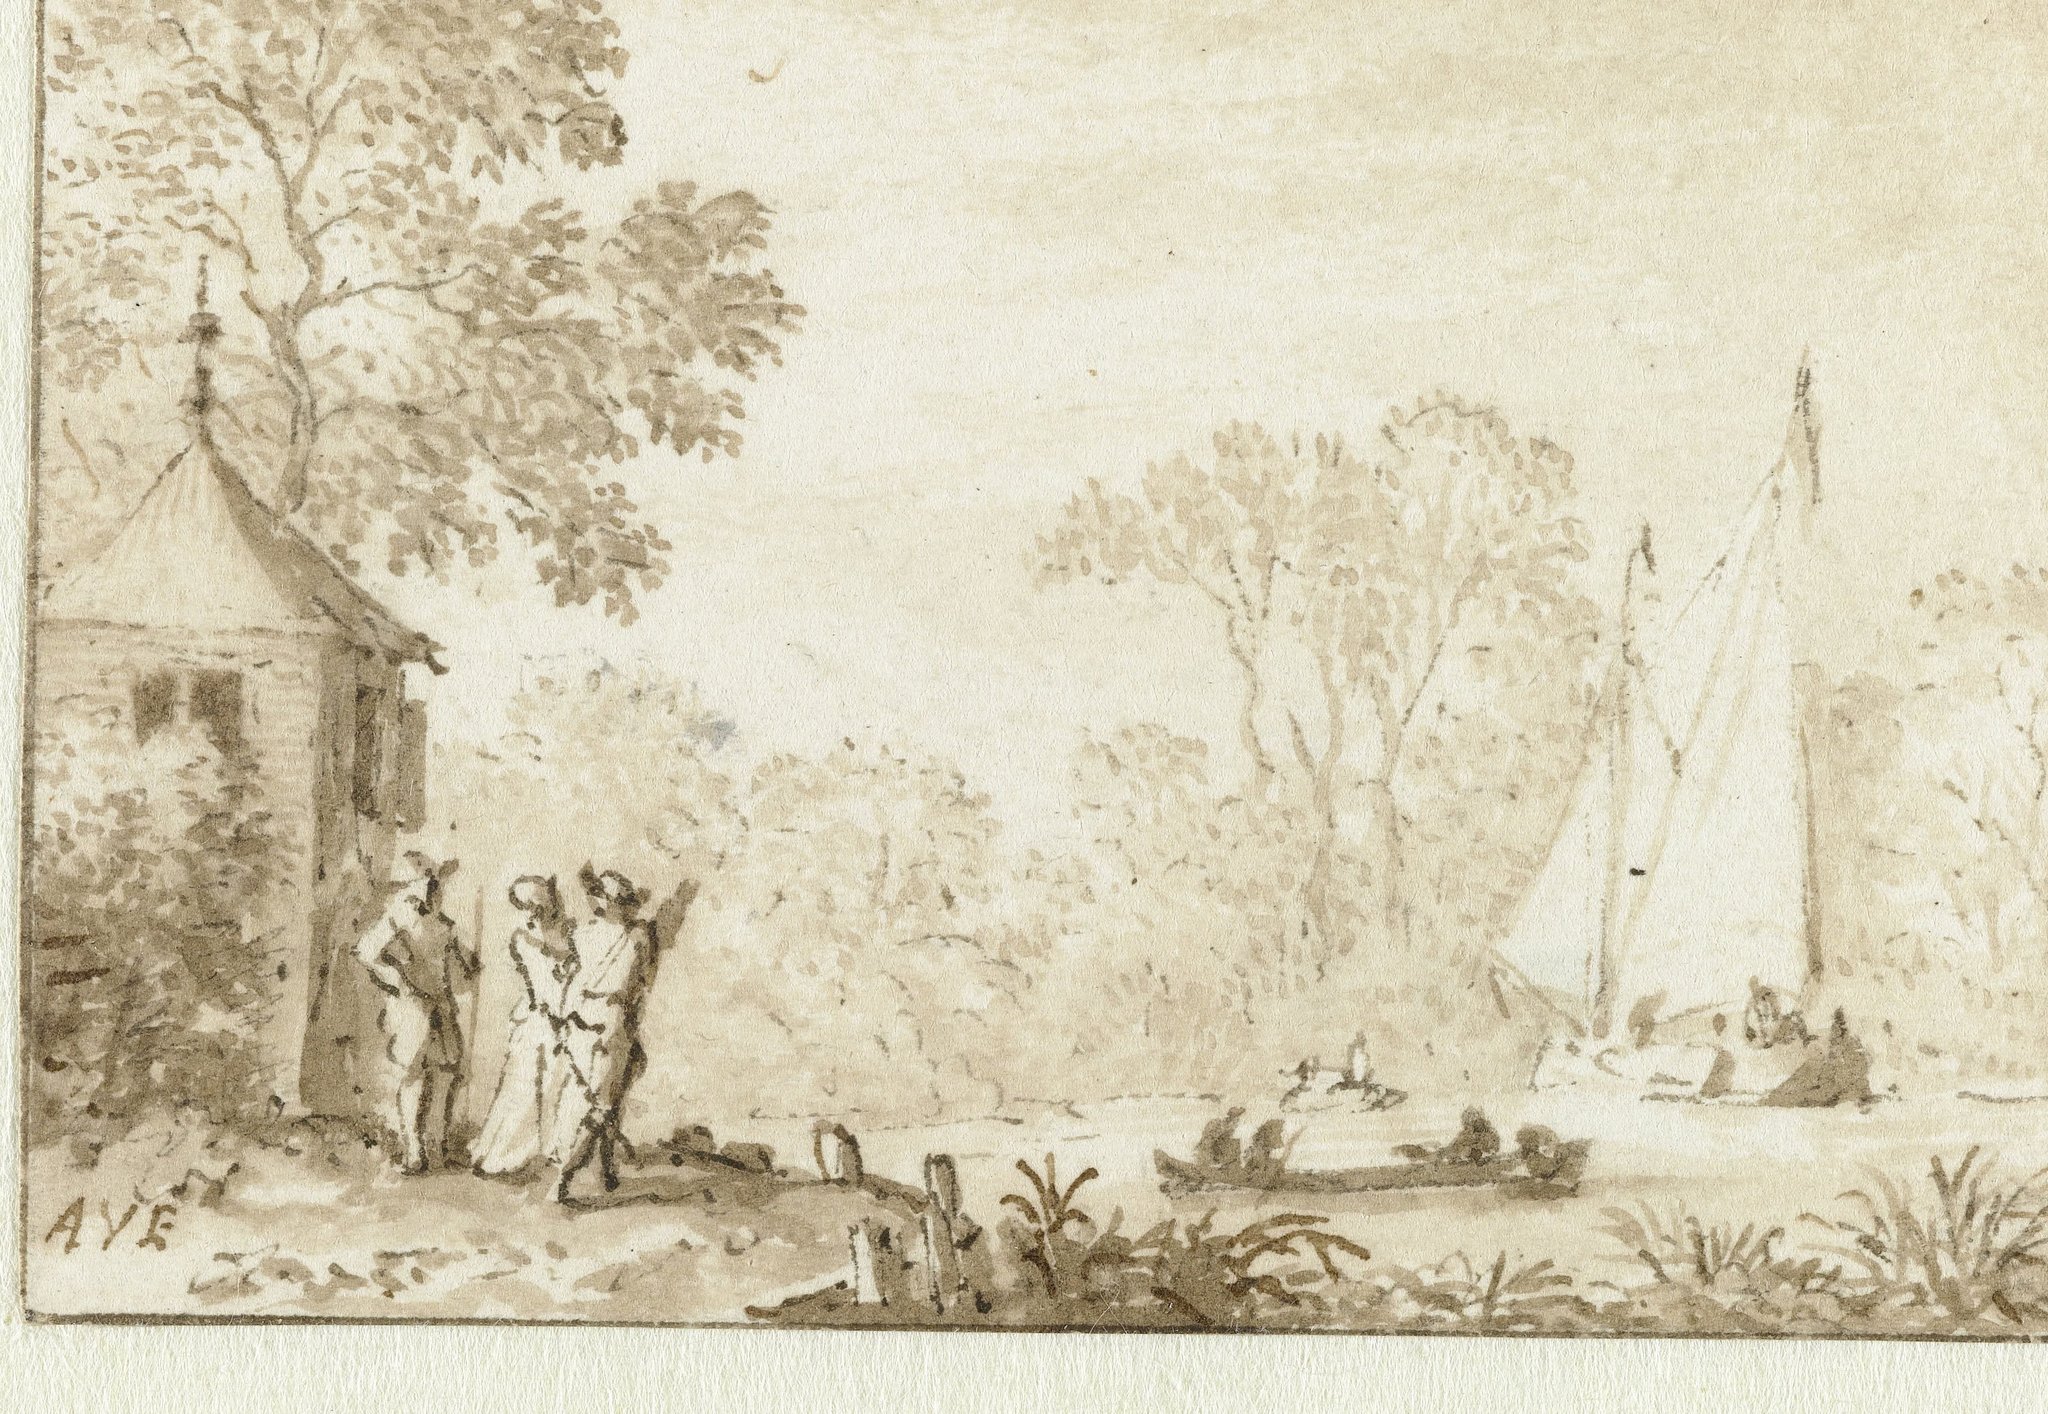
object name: drawing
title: Landschap met drie figuren aan de oever van een water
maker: allaert van everdingen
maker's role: draughtsman, painter, print maker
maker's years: 1621-1675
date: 1631-1675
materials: ink, paper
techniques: brush, pen